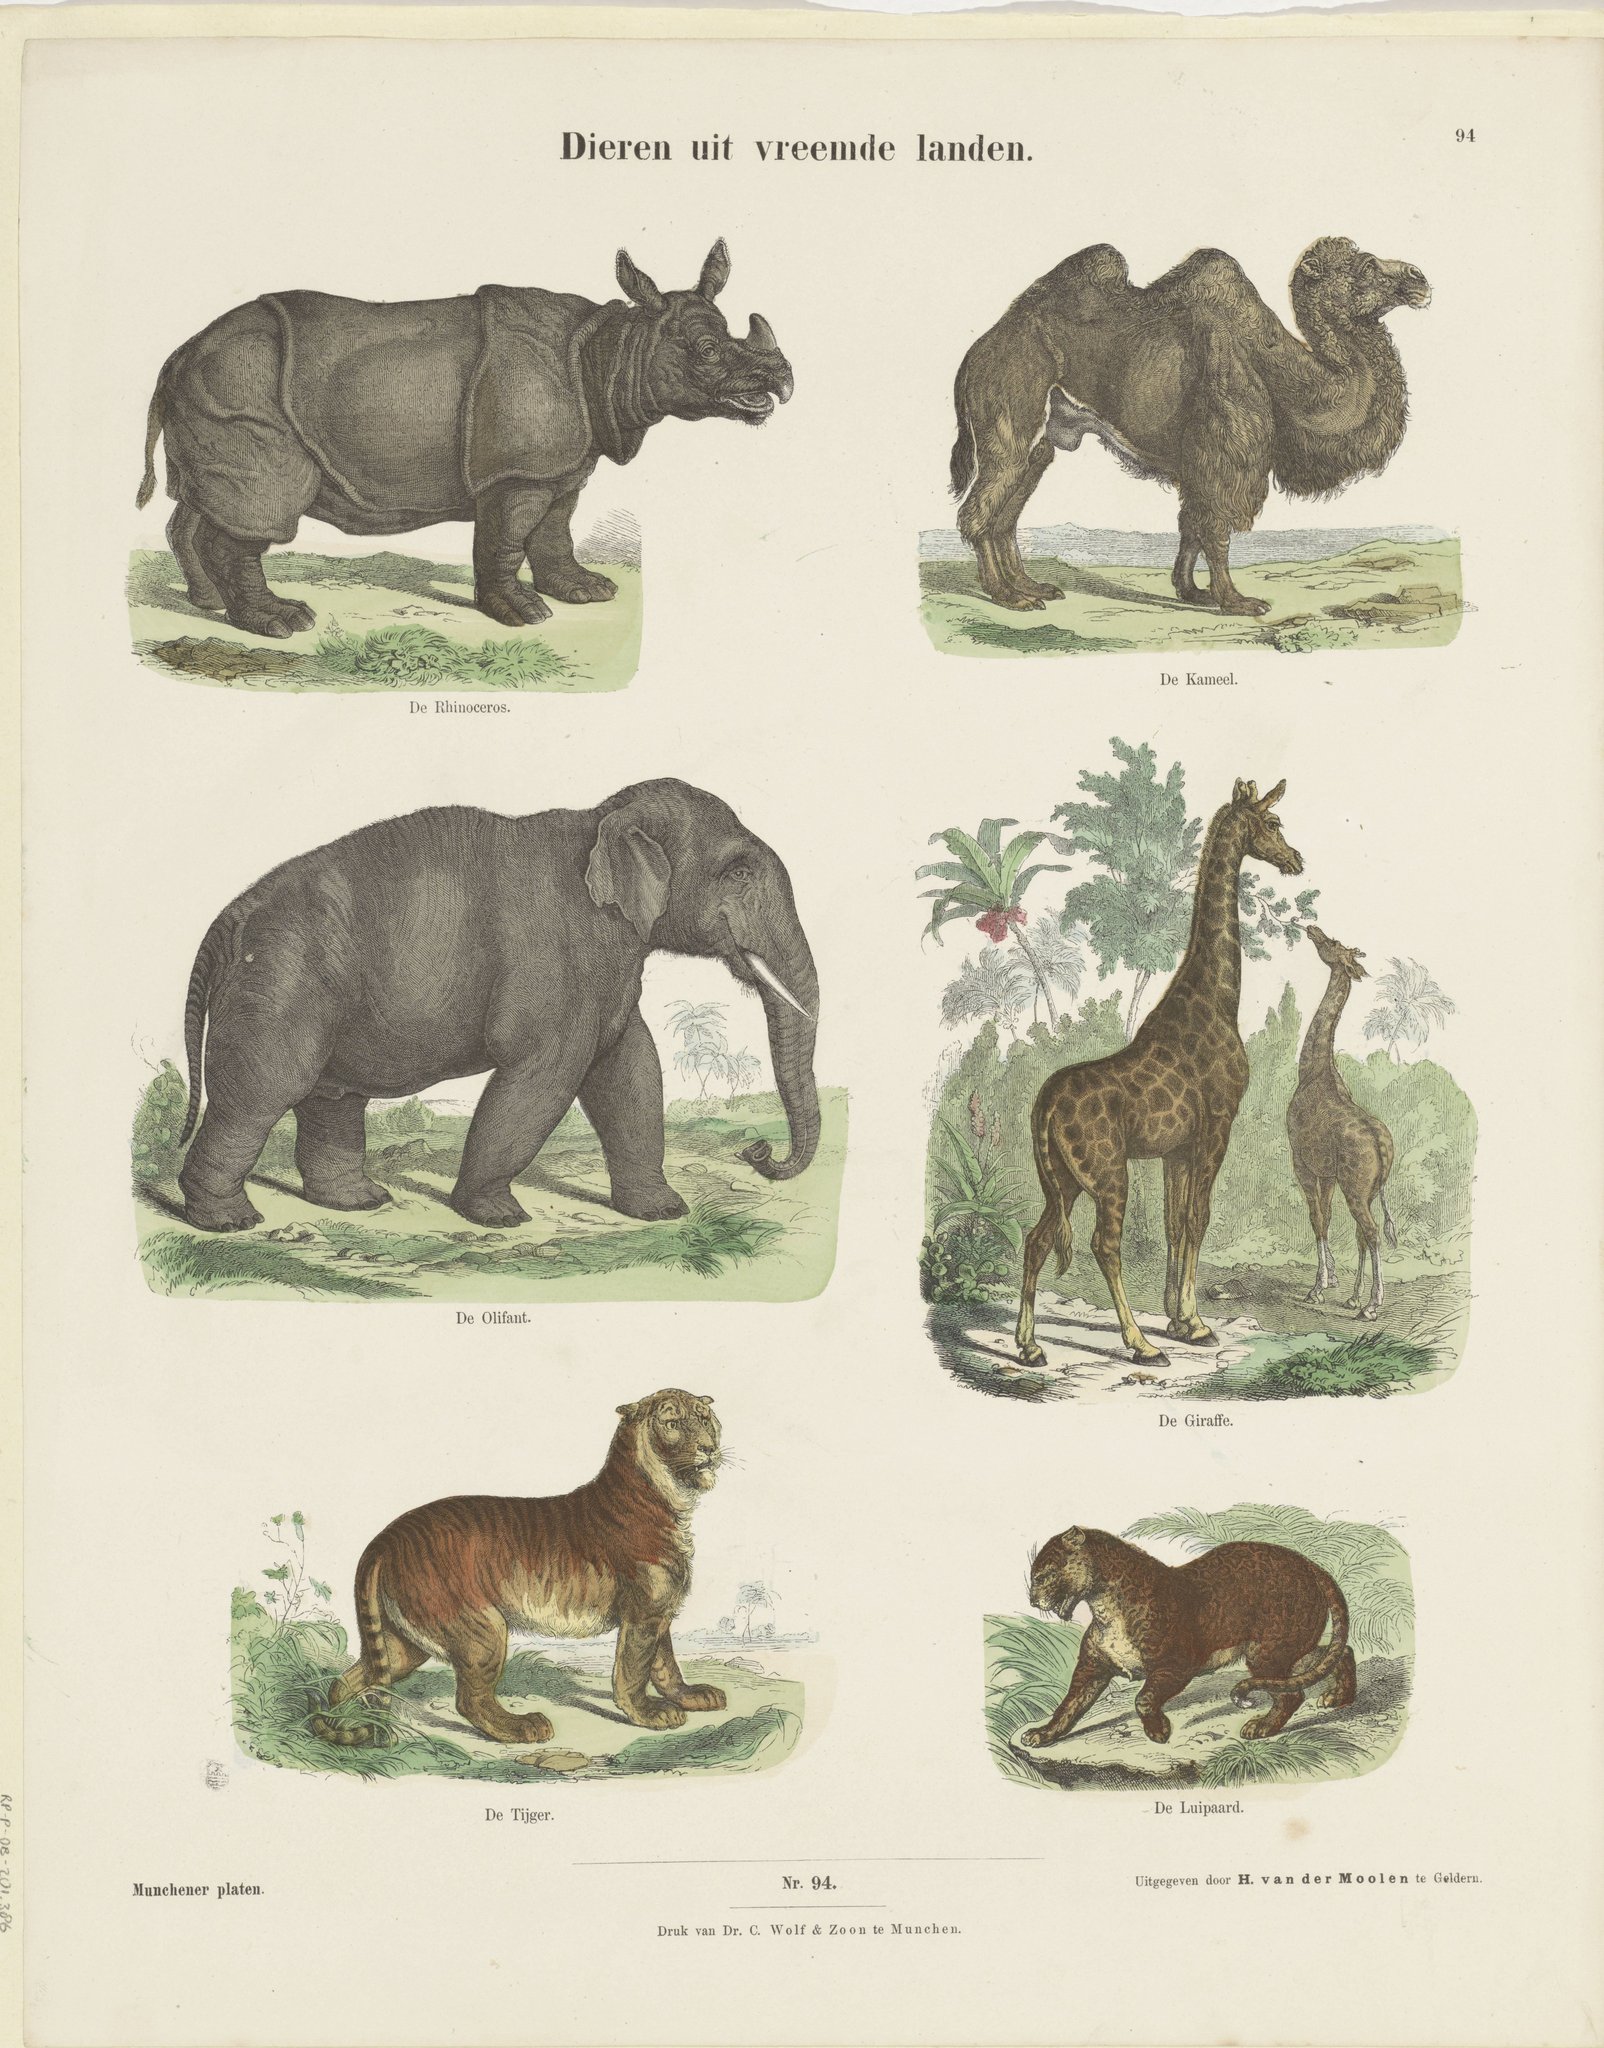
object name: print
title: Munchener platen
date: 1820-1843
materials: paper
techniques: colour, letterpress printing, engraving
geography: geldern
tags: hoofed animals: camel, beasts of prey, predatory animals: tiger, beasts of prey, predatory animals: leopard, hoofed animals: rhinoceros, hoofed animals: giraffe, trunked animals: elephant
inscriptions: collector's mark: Lugt 2760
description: Blad met 6 voorstellingen van dieren, waaronder een neushoorn, een kameel, een olifant, giraffen, een tijger en een luipaard. Onder de afbeeldingen een onderschrift. Genummerd midden onder: Nro. 94. Genummerd rechtsboven: 94.